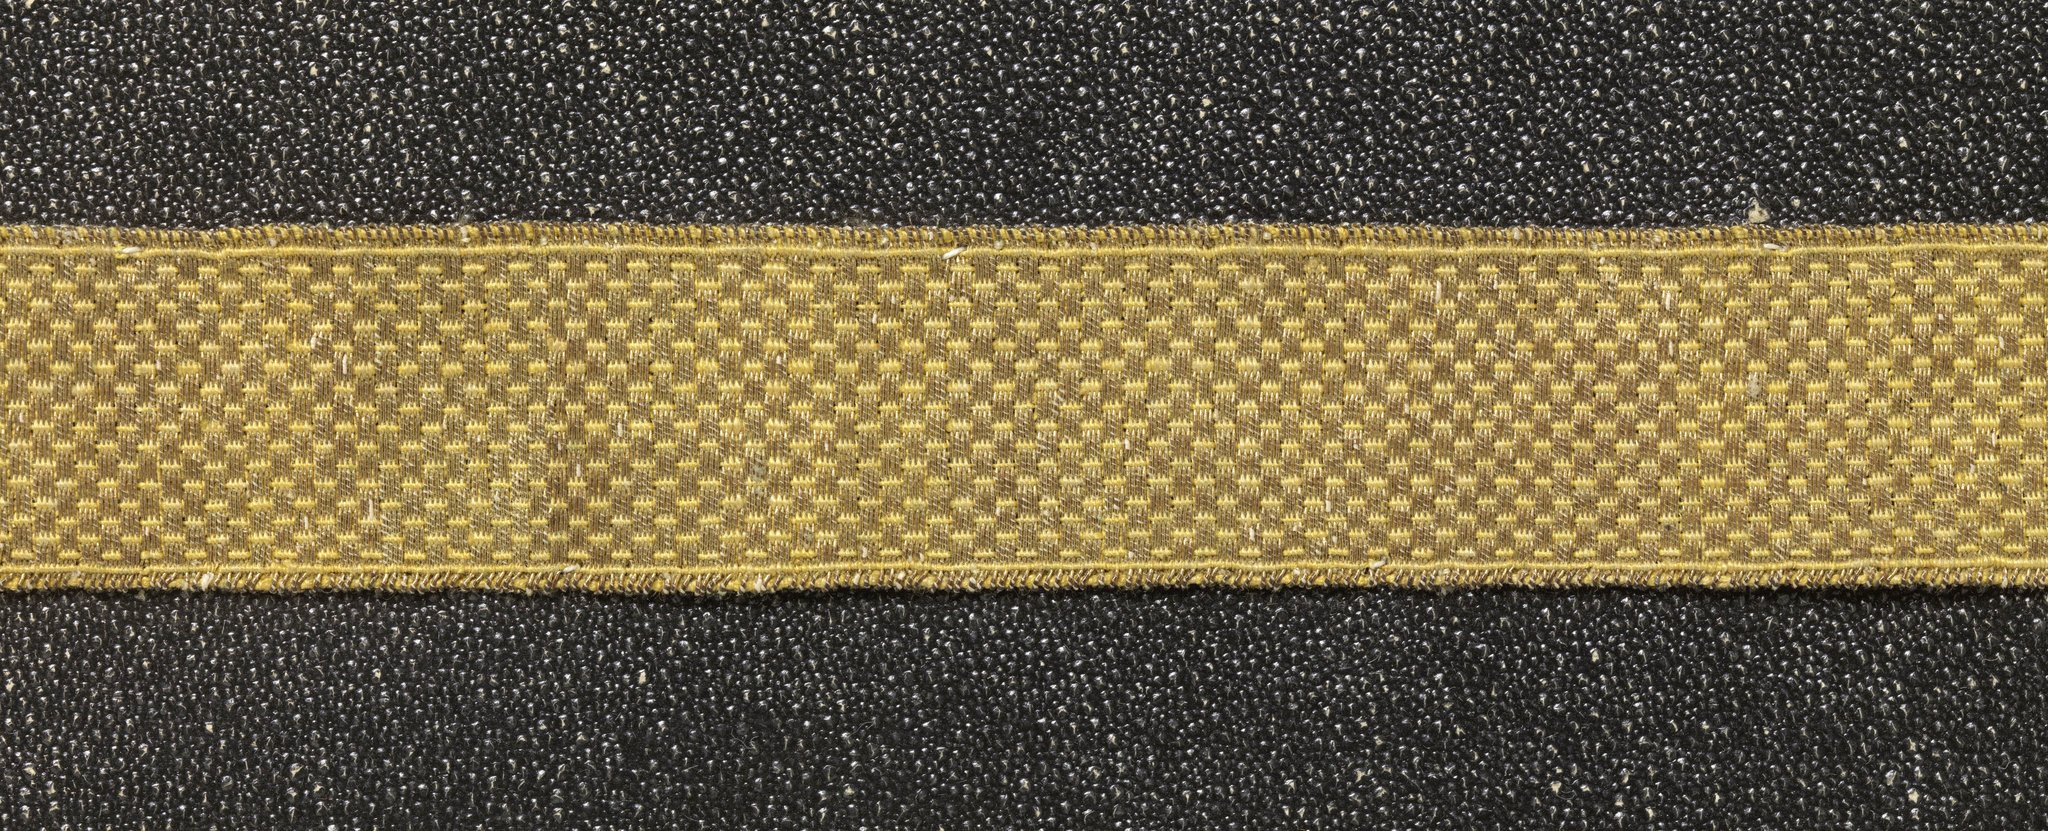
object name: strip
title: Strook passement met gouddraad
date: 1800-1900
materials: gold thread